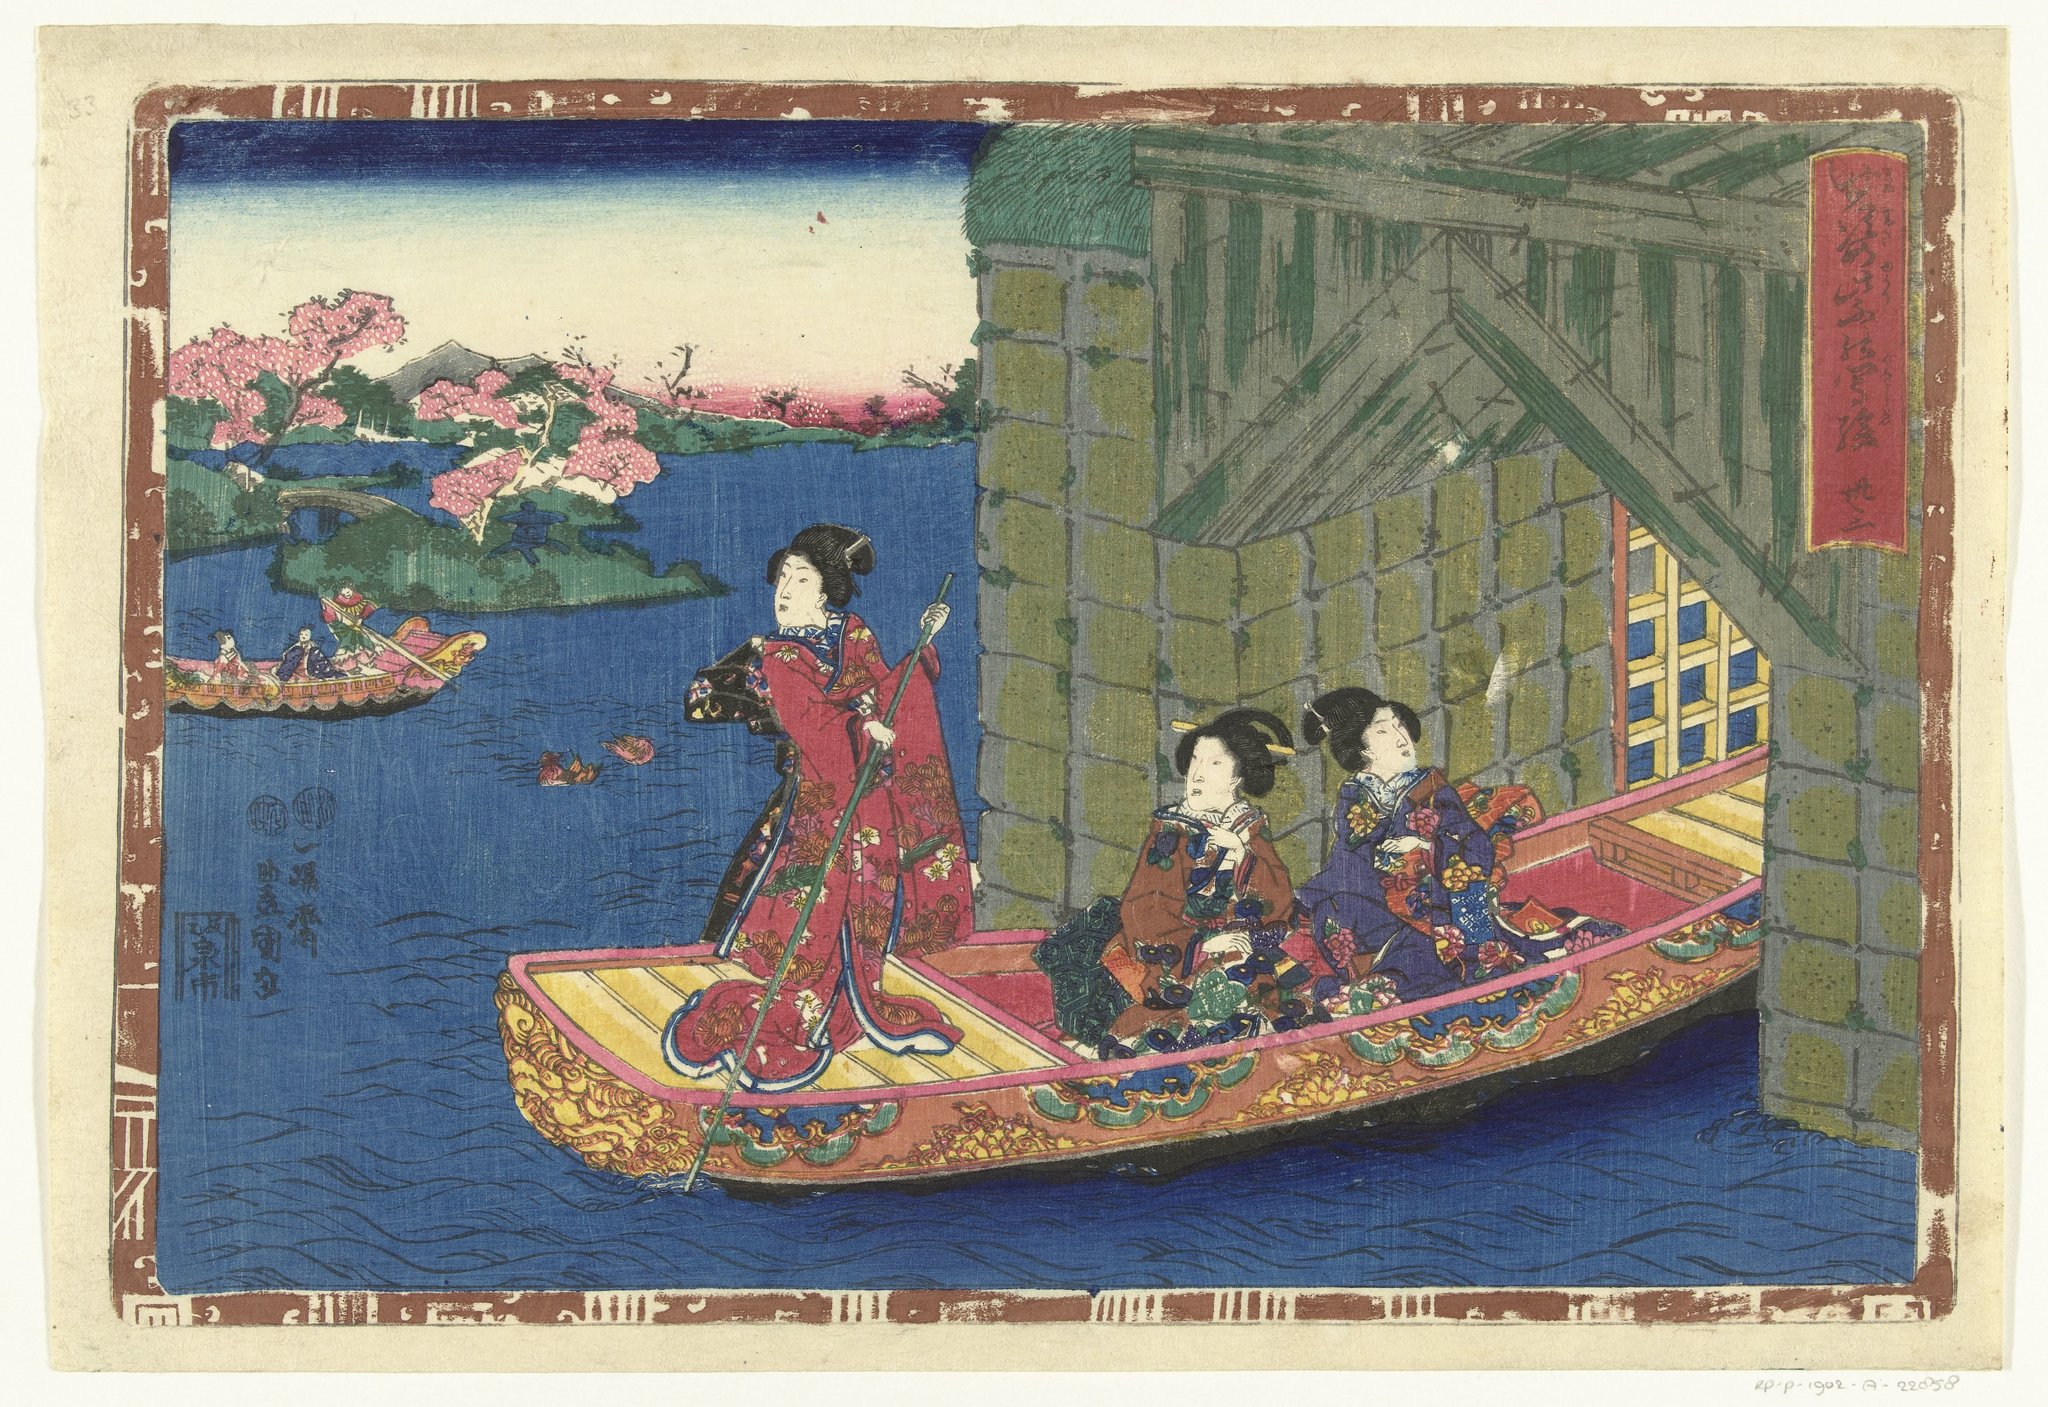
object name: print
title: Sono sugata Hikaru no utsushi-e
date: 1851-1853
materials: paper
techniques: woodcut, nishiki e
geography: japan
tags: passengers ~ ship, rowing-boat, canoe, etc., adult woman (+ three persons)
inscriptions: collector's mark: Lugt 2228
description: Drie vrouwen in een roeiboot varend door tunnel; op de achtergrond een tweede roeiboot en landschap met bloesemende bomen. Voorstelling omsloten door bruine rand waarin Genji emblemen.